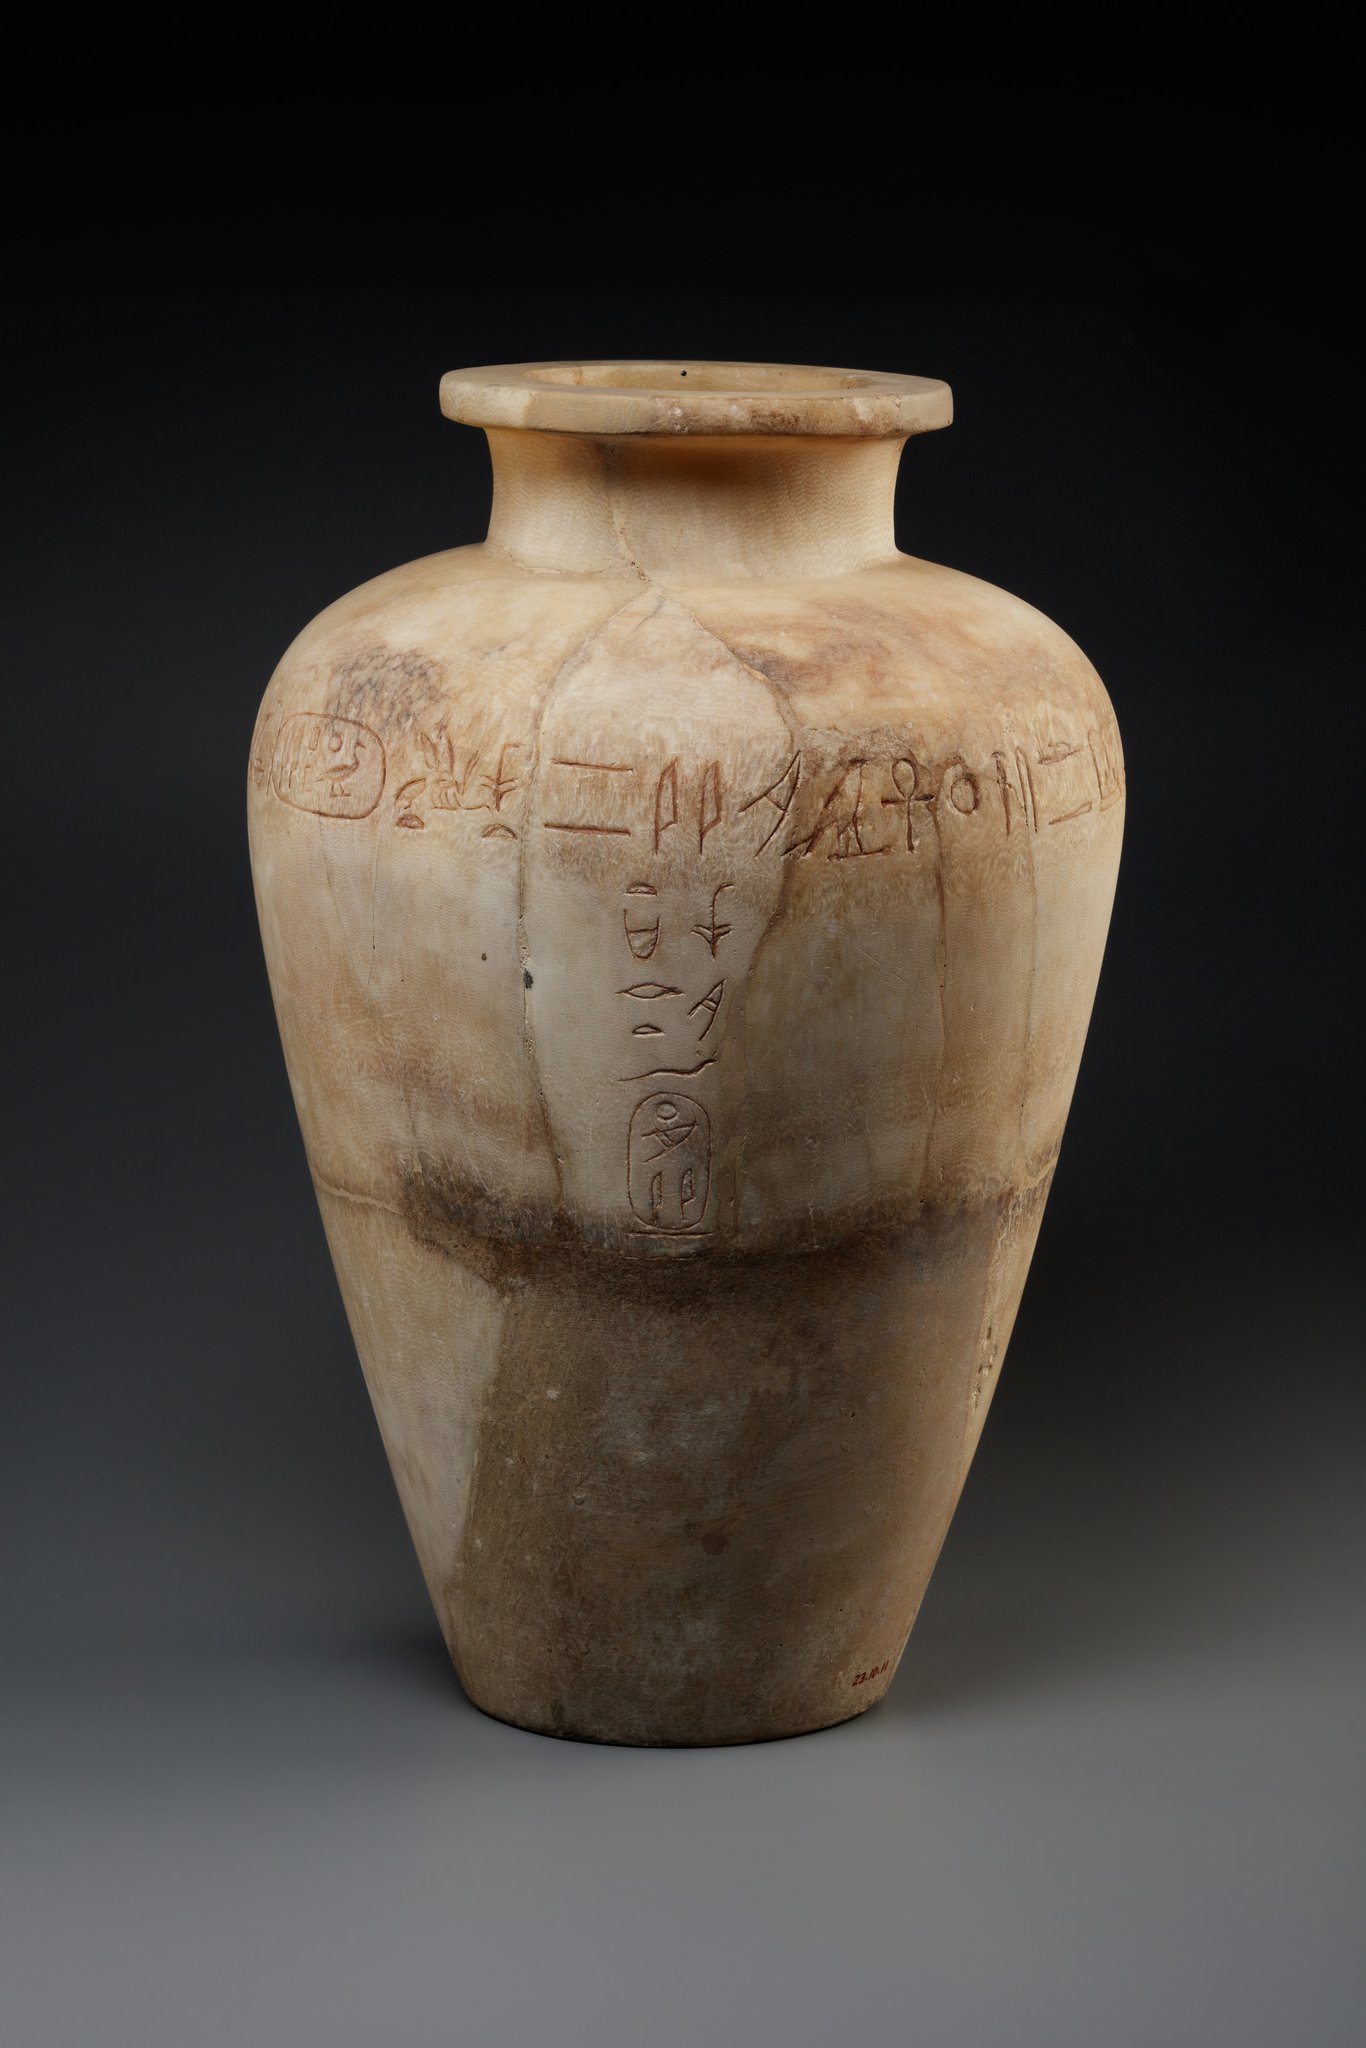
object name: jar, pepi i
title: Jar of Pepi I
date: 2289-2255 BCE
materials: stone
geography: egypt